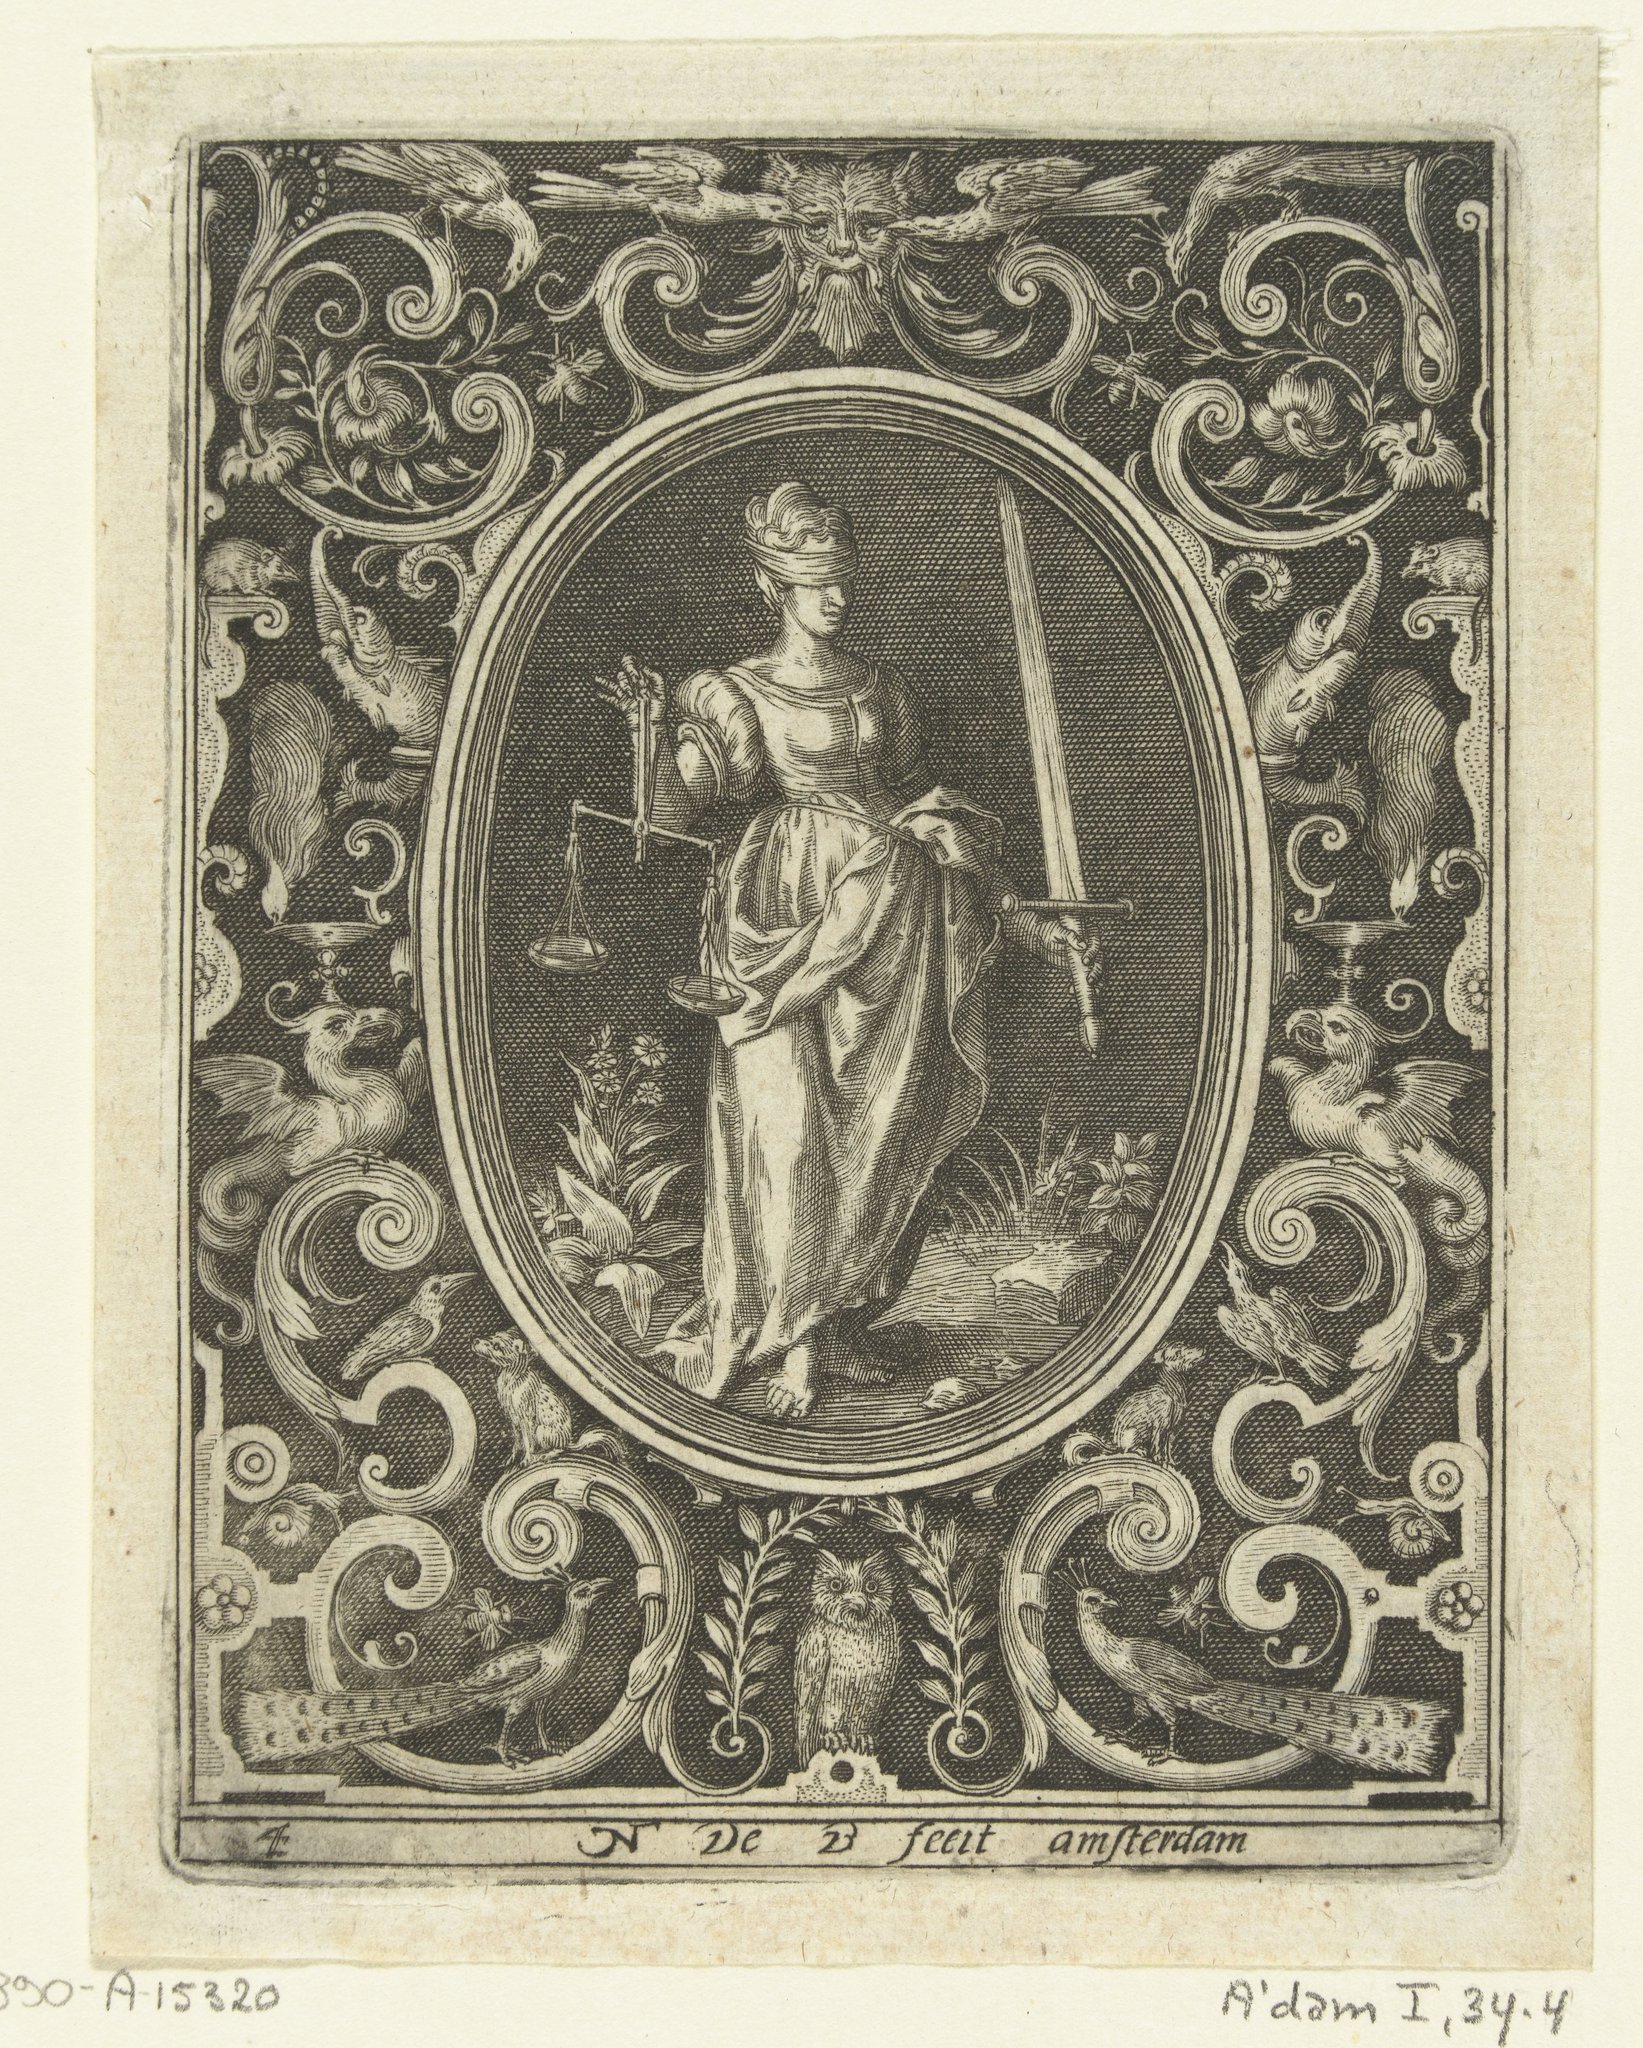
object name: ornament print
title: Vlakdecoraties. Ovalen met vier deugden in een omlijsting van grotesken met dieren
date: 1639-1706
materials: paper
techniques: engraving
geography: netherlands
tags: justice, 'justitia'; 'giustitia divina' (ripa) ~ one of the four cardinal virtues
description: Blad 4 van serie van 4 genummerde bladen met vlakdecoraties. Justitia, personificatie van de Gerechtigheid, staand in ovaal. In de omlijsting zit onderaan een uil tussen twee pauwen. Gearceerde achtergrond.